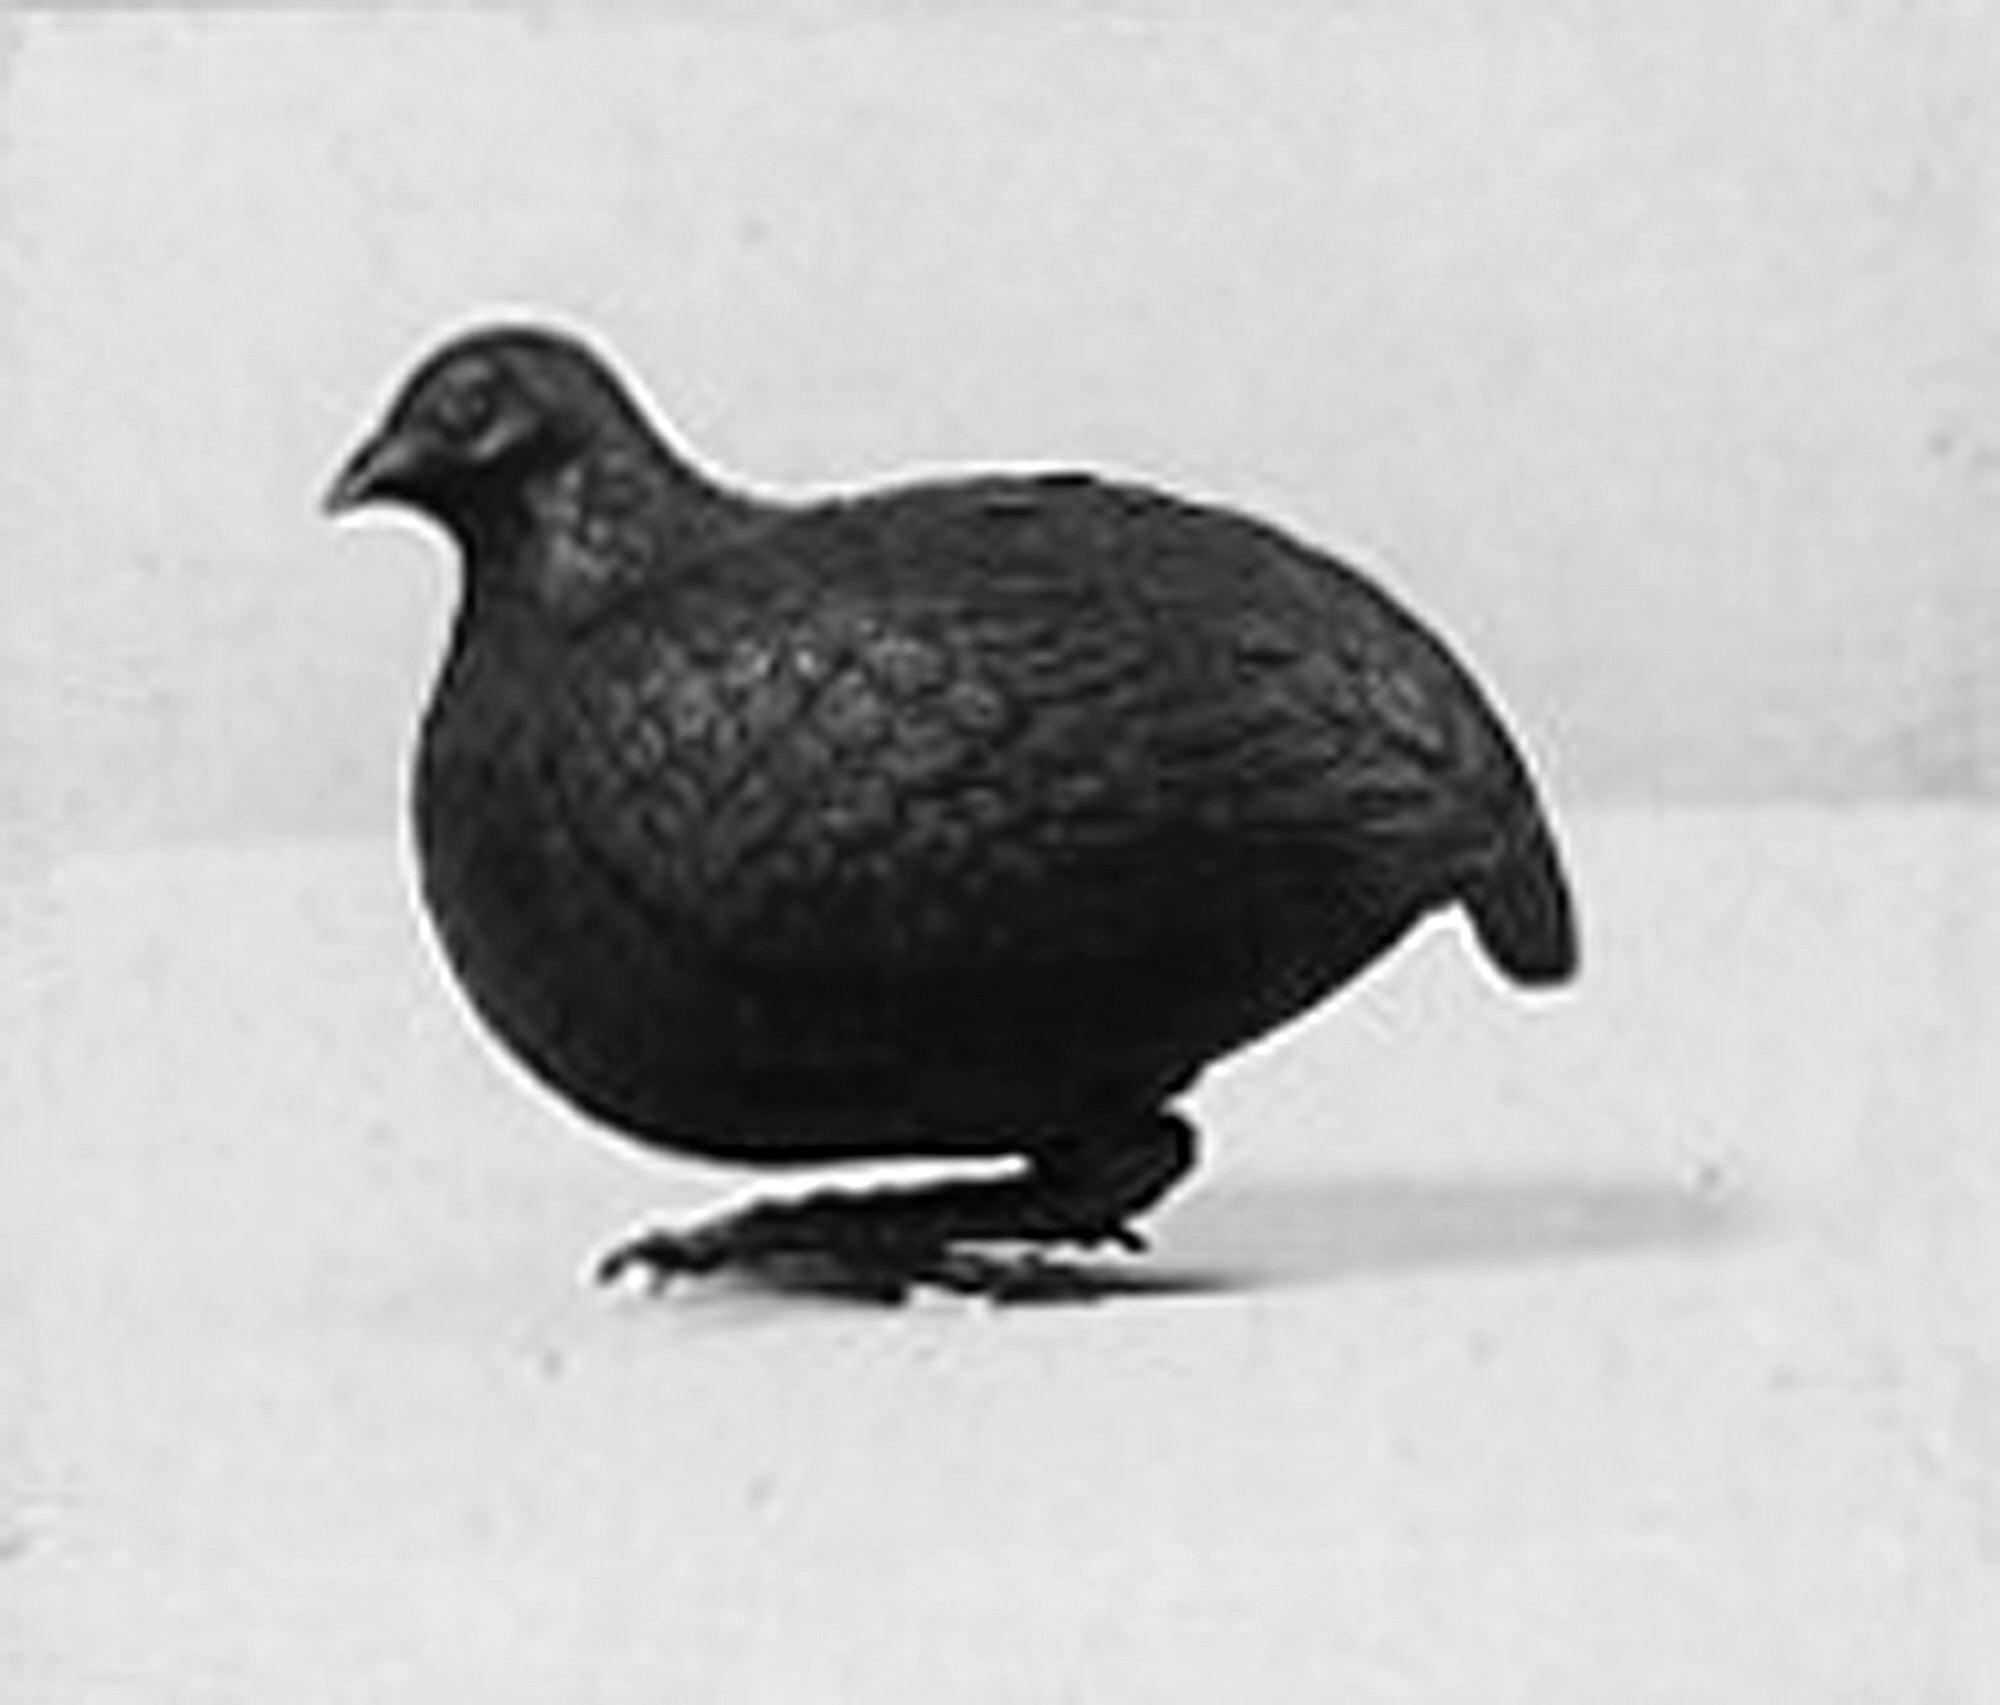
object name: incense burner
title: Incense Burner in Shape of Quail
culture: japanese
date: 1801-1900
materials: gold, iron, silver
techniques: inlay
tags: birds